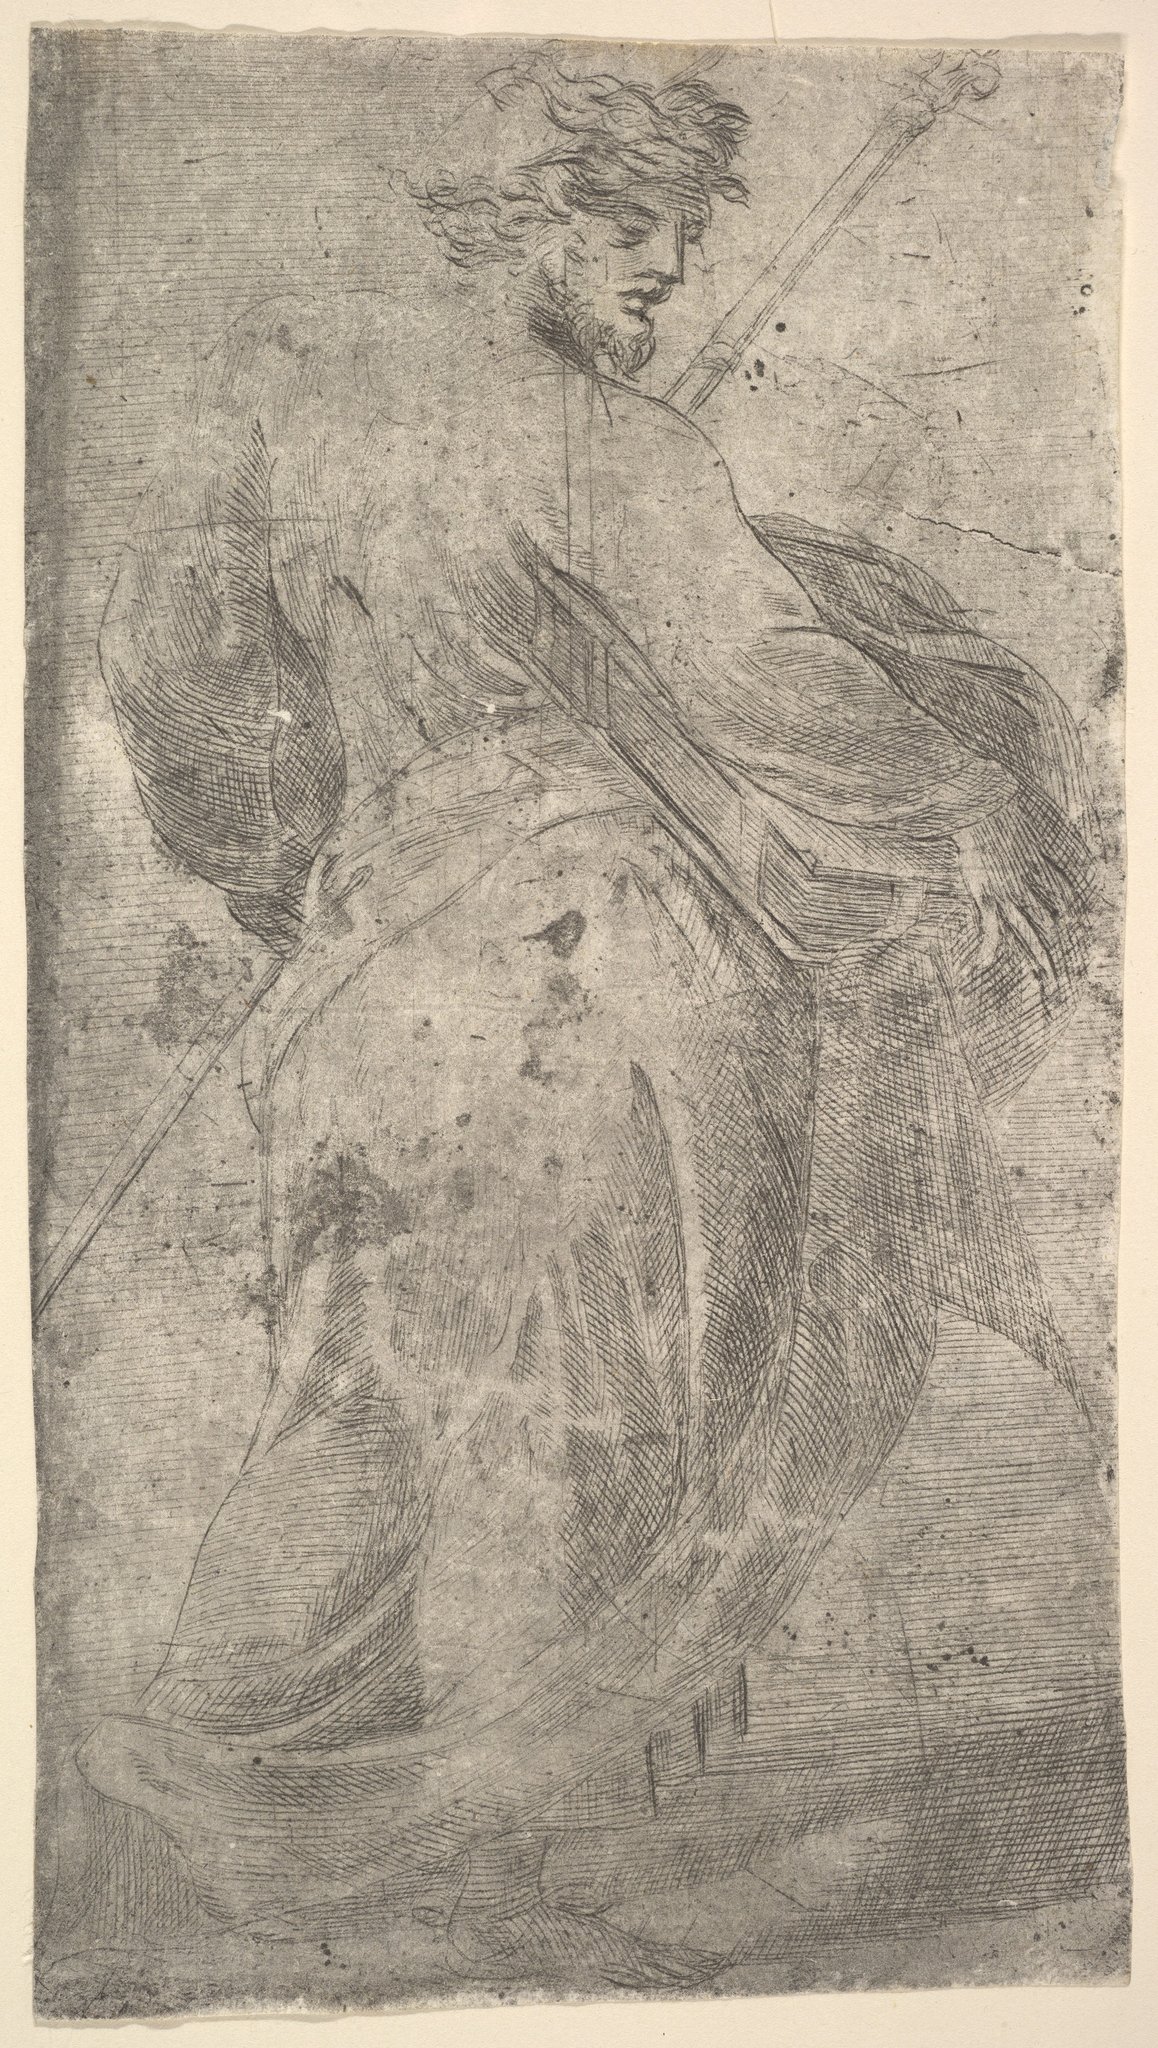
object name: print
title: Saint James Major, a staff in his left hand, book in his right, from "Christ and the Apostles"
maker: andrea schiavone (andrea meldola)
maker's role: artist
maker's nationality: italian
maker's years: 1510-1563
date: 1548-1550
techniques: etching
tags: books,saints